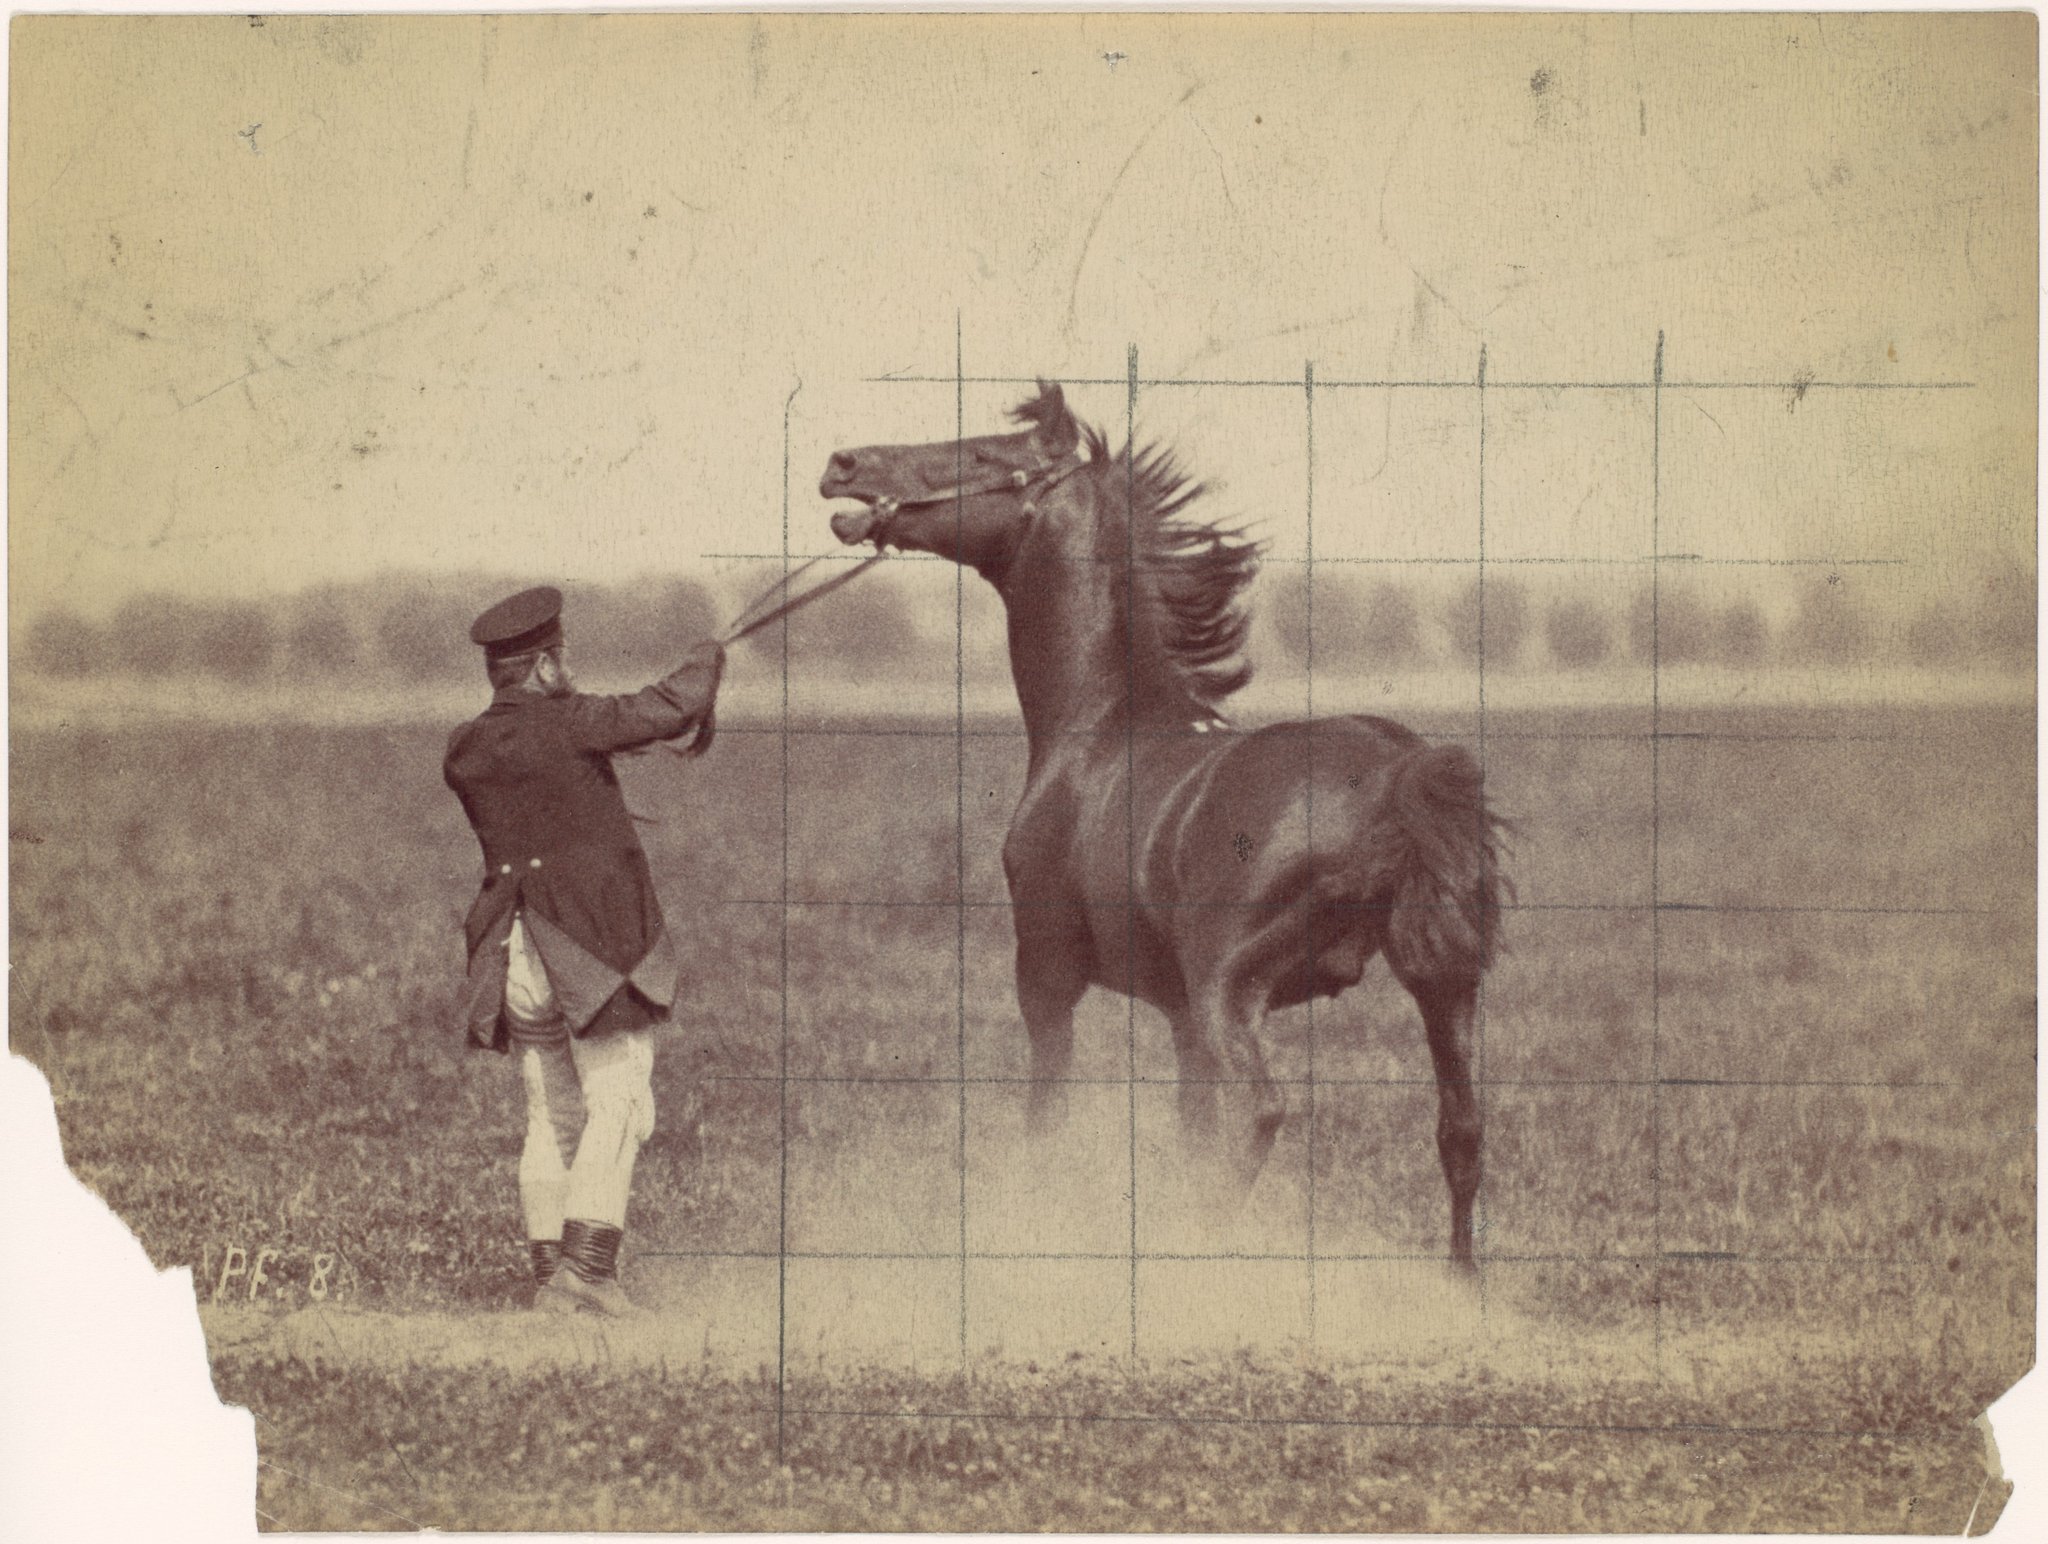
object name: photograph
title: Horse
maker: ottomar anschütz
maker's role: fotograaf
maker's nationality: german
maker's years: 1846-1907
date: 1884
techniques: albumen silver print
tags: men,horses